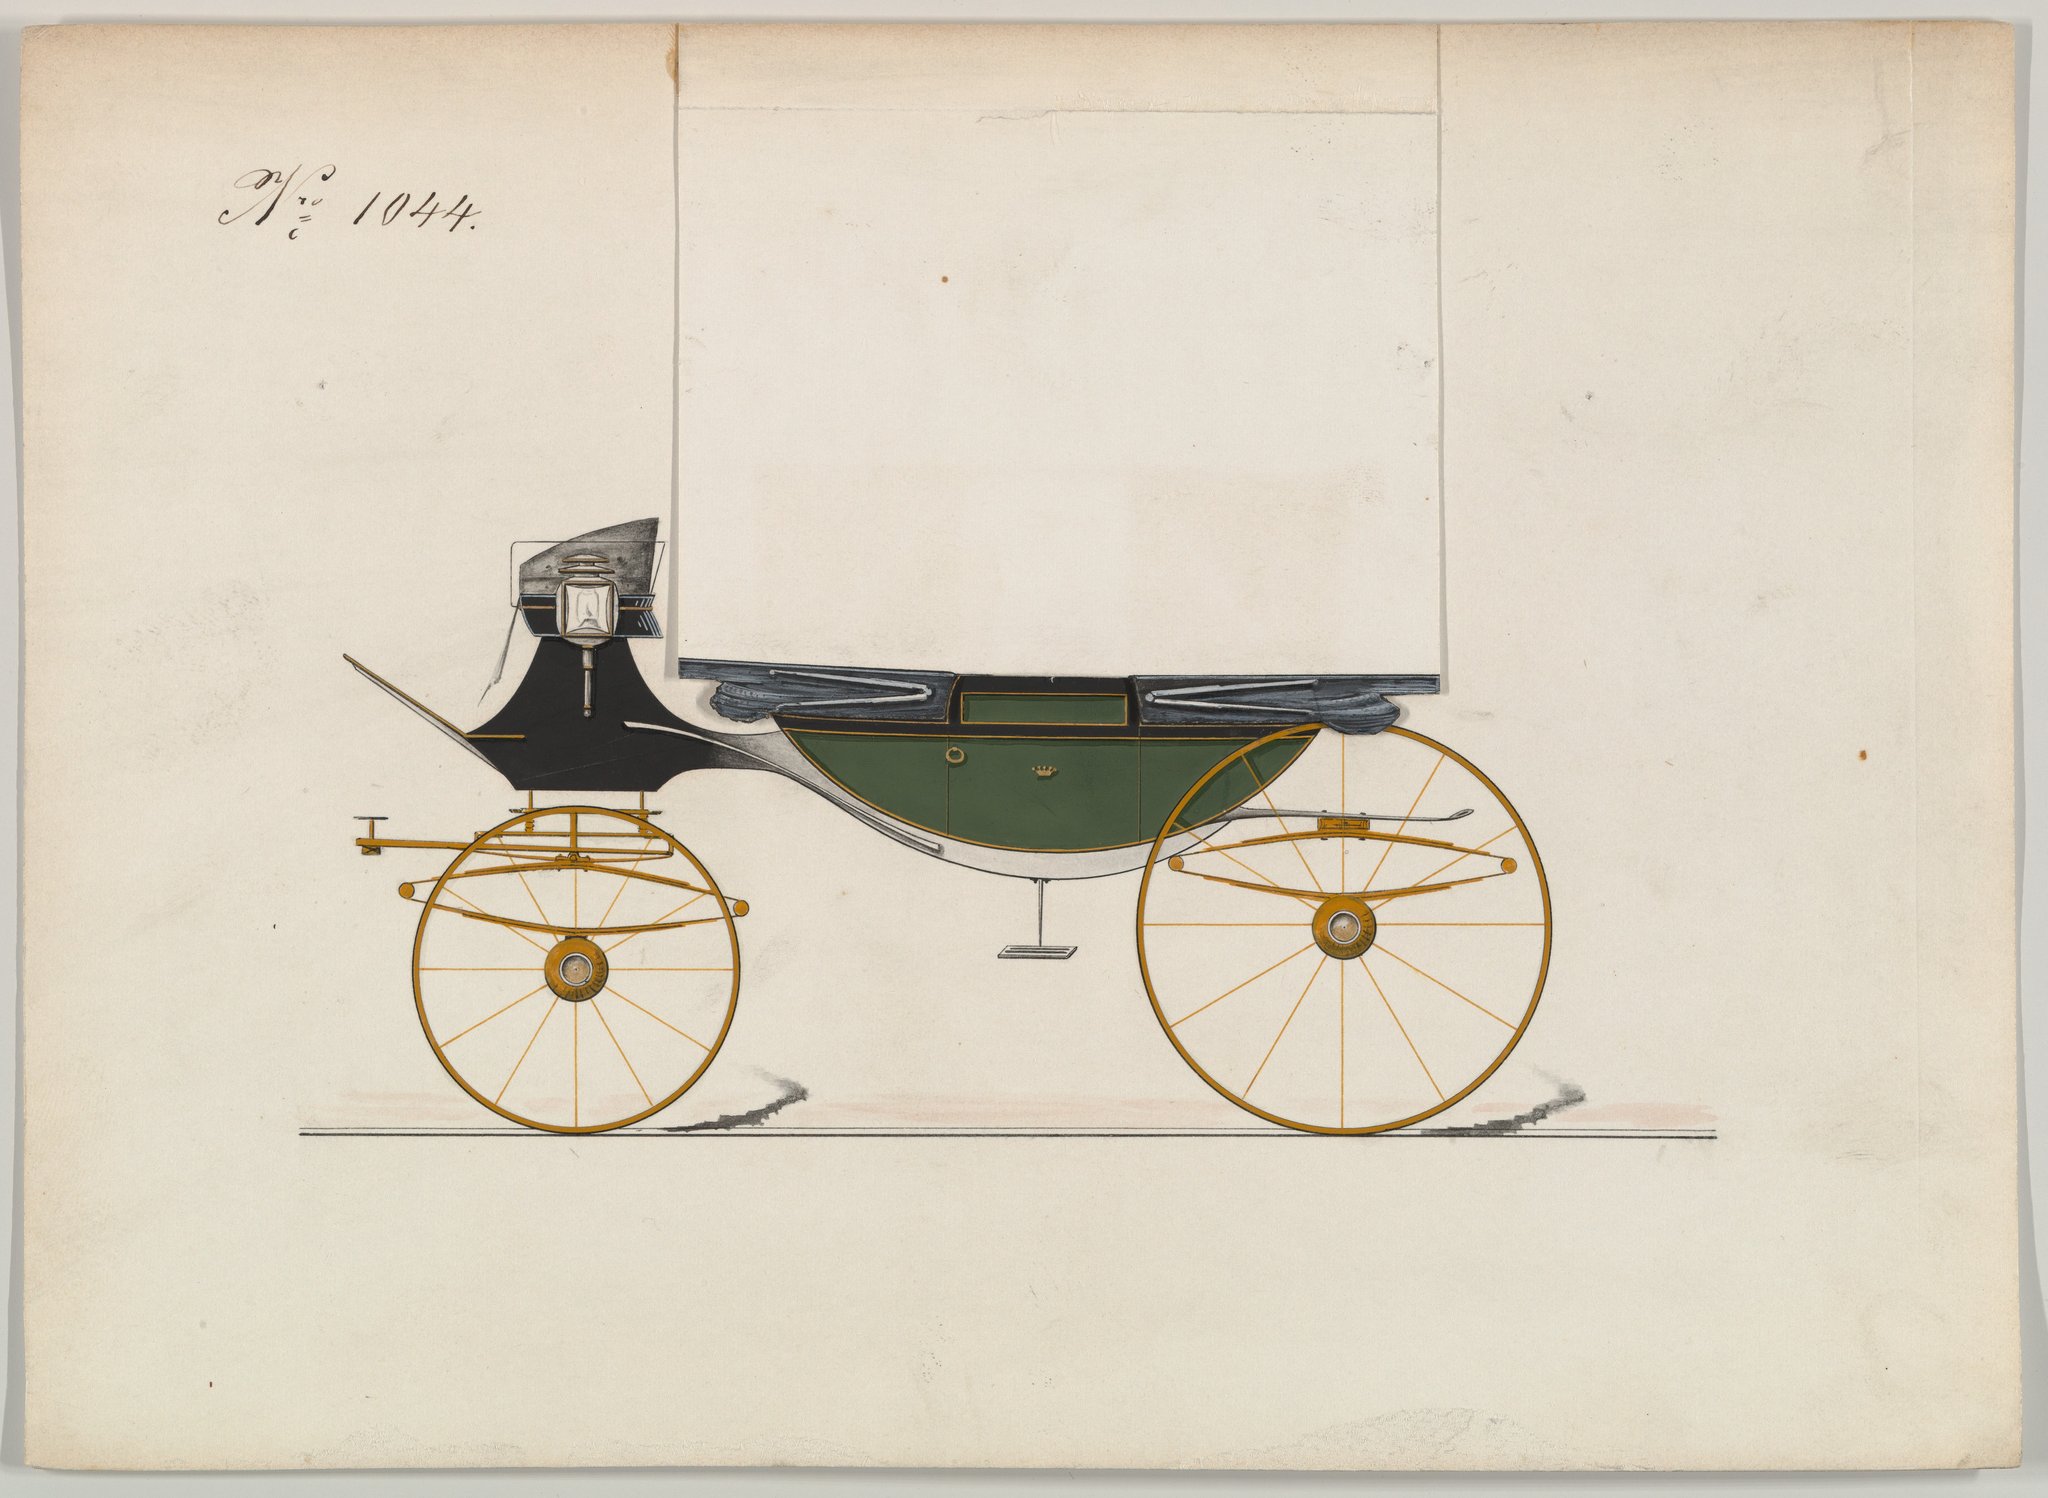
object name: drawing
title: Landau #1044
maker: brewster & co.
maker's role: manufacturer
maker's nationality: american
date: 1850-1870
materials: gouache, gum arabic, ink, watercolor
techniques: pen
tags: carriages